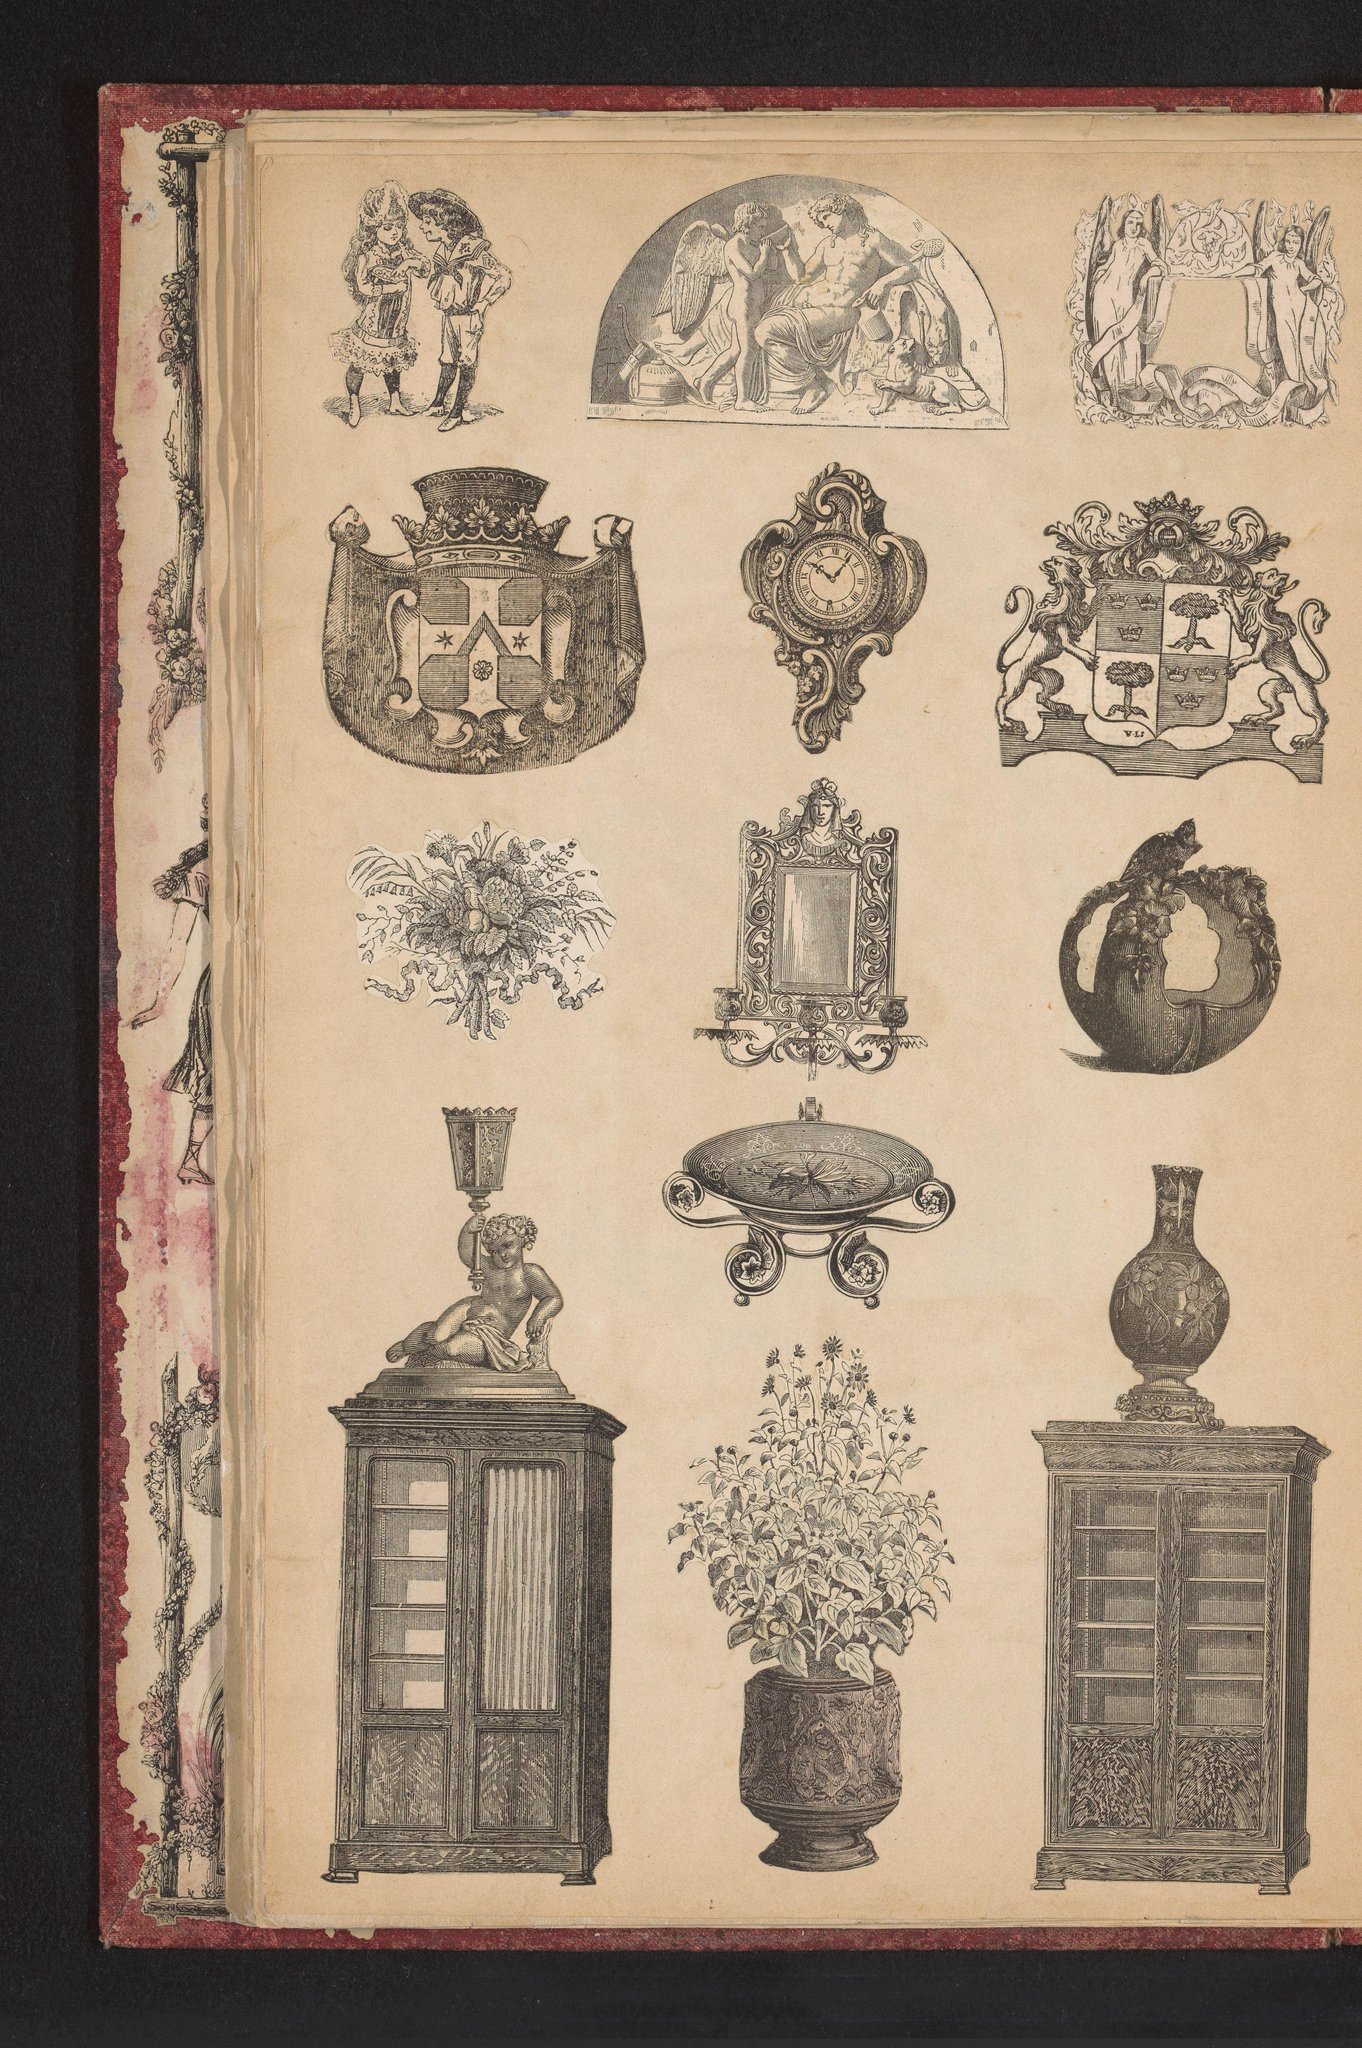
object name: collage visual work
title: Collage van uitgeknipte prenten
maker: Anonymous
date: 1870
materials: paper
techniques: engraving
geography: paris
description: Collage van uitgeknipte prenten. Onderdeel van een album met 32 bladen, aan beide zijden beplakt met uitgeknipte prenten, vermoedelijk afkomstig uit 19e-eeuwse tijdschiften.